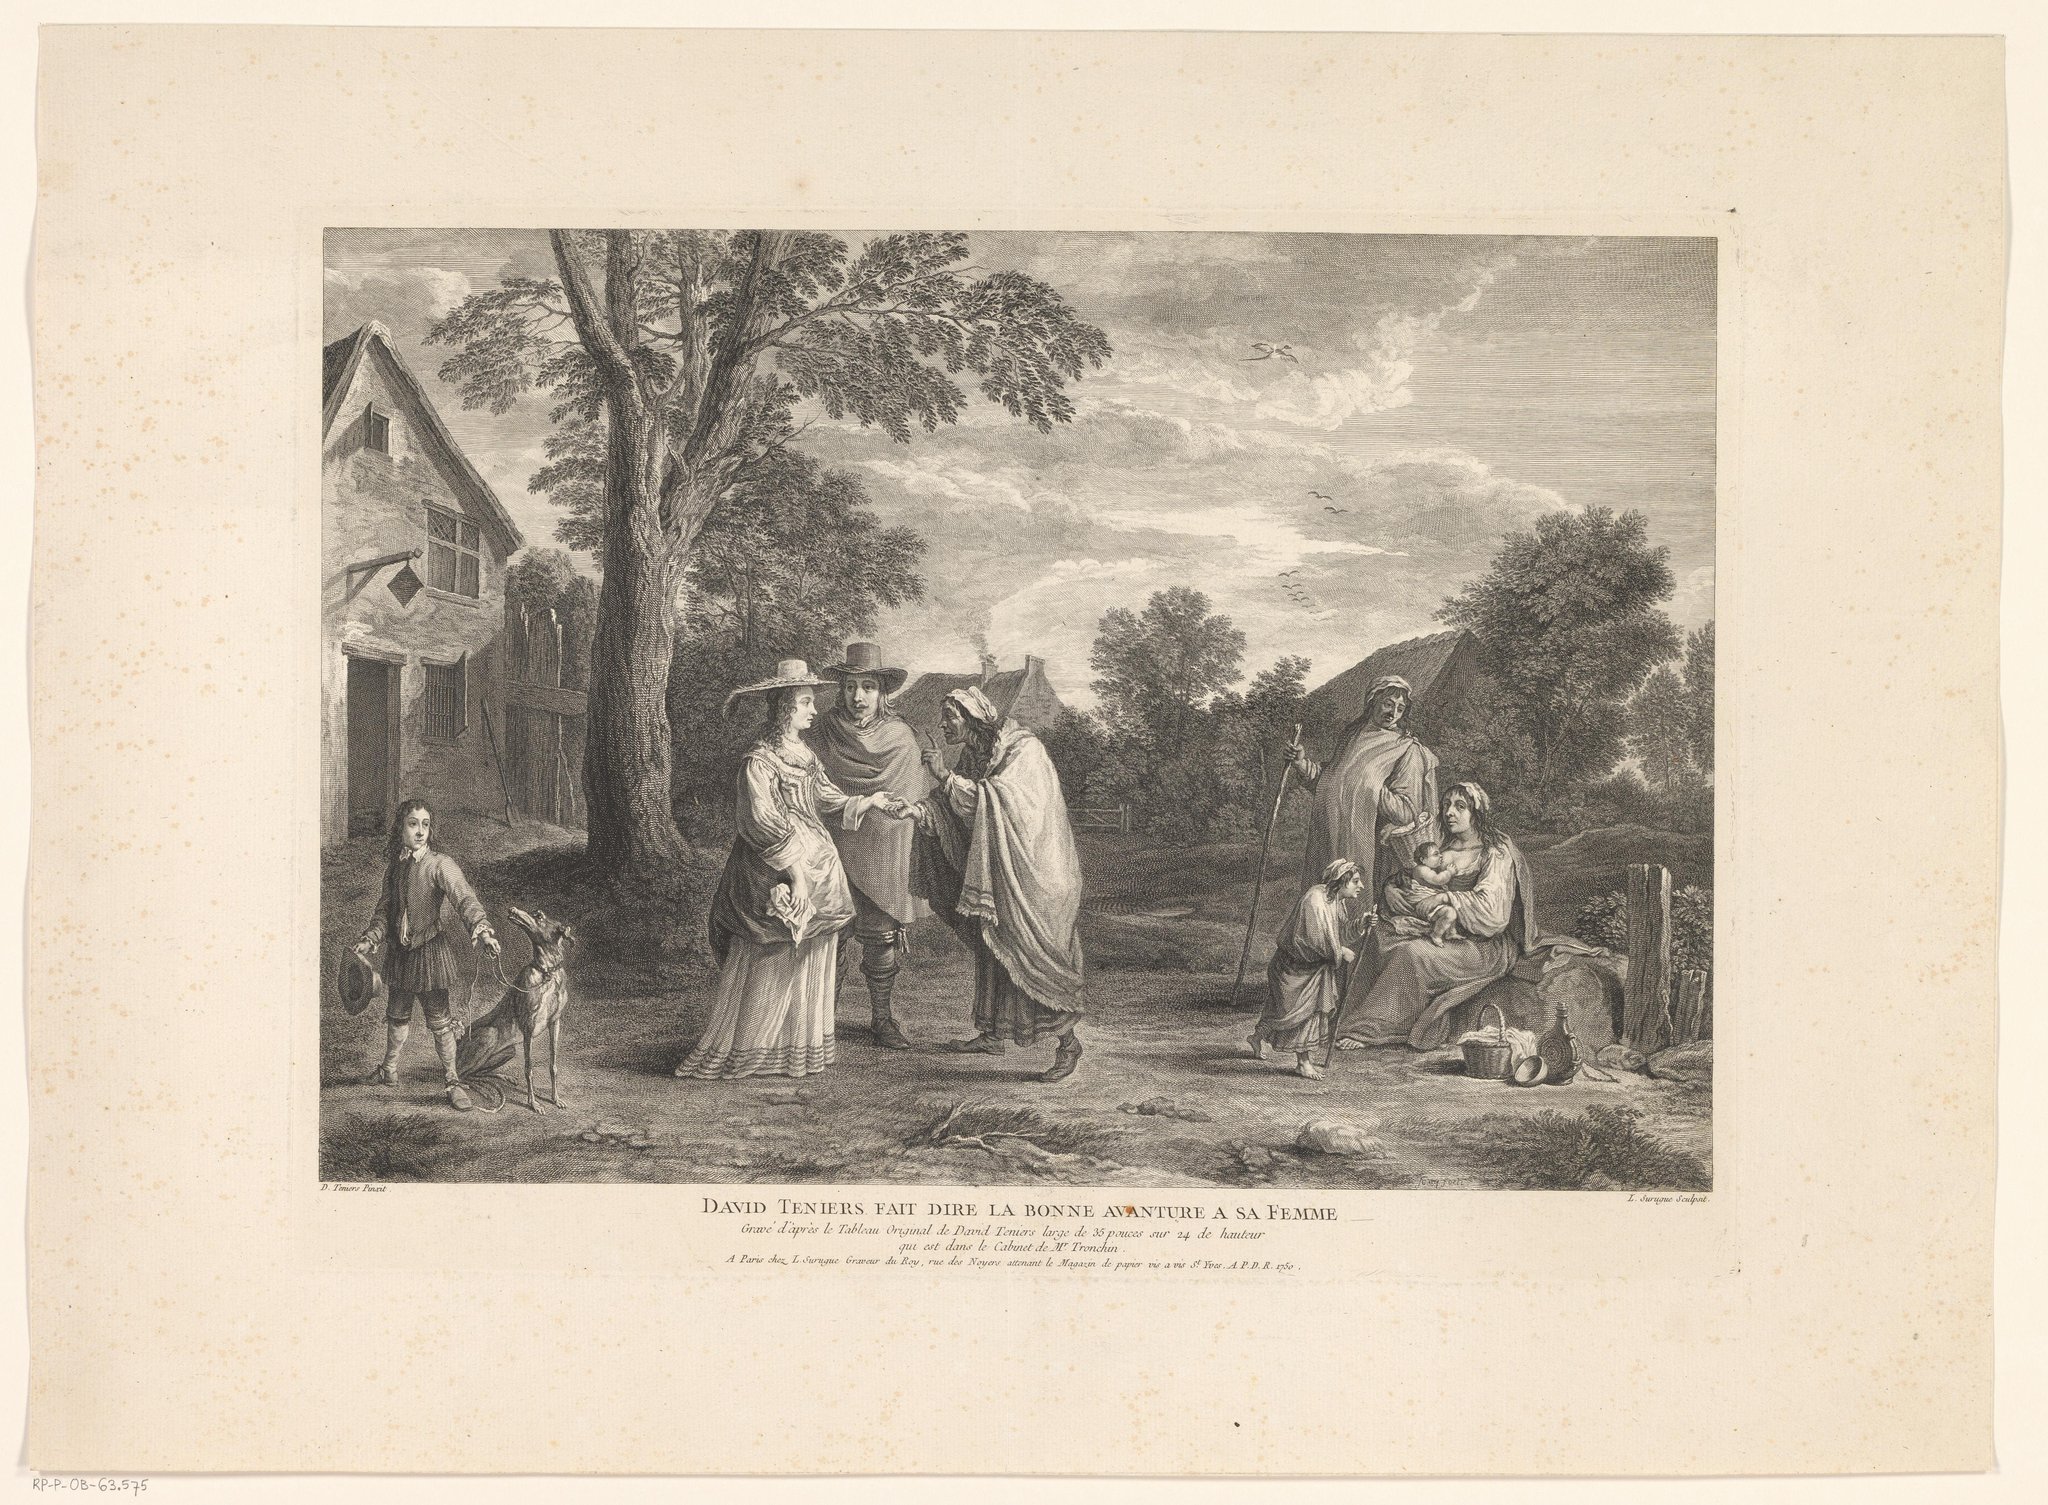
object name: print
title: David Teniers laat de toekomst van zijn vrouw voorspellen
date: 1750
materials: paper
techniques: engraving, etching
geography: paris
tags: david teniers, historical persons, fortune-teller ~ pleasure fair and circus - aa - fortune-teller (female)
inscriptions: collector's mark: Lugt 240